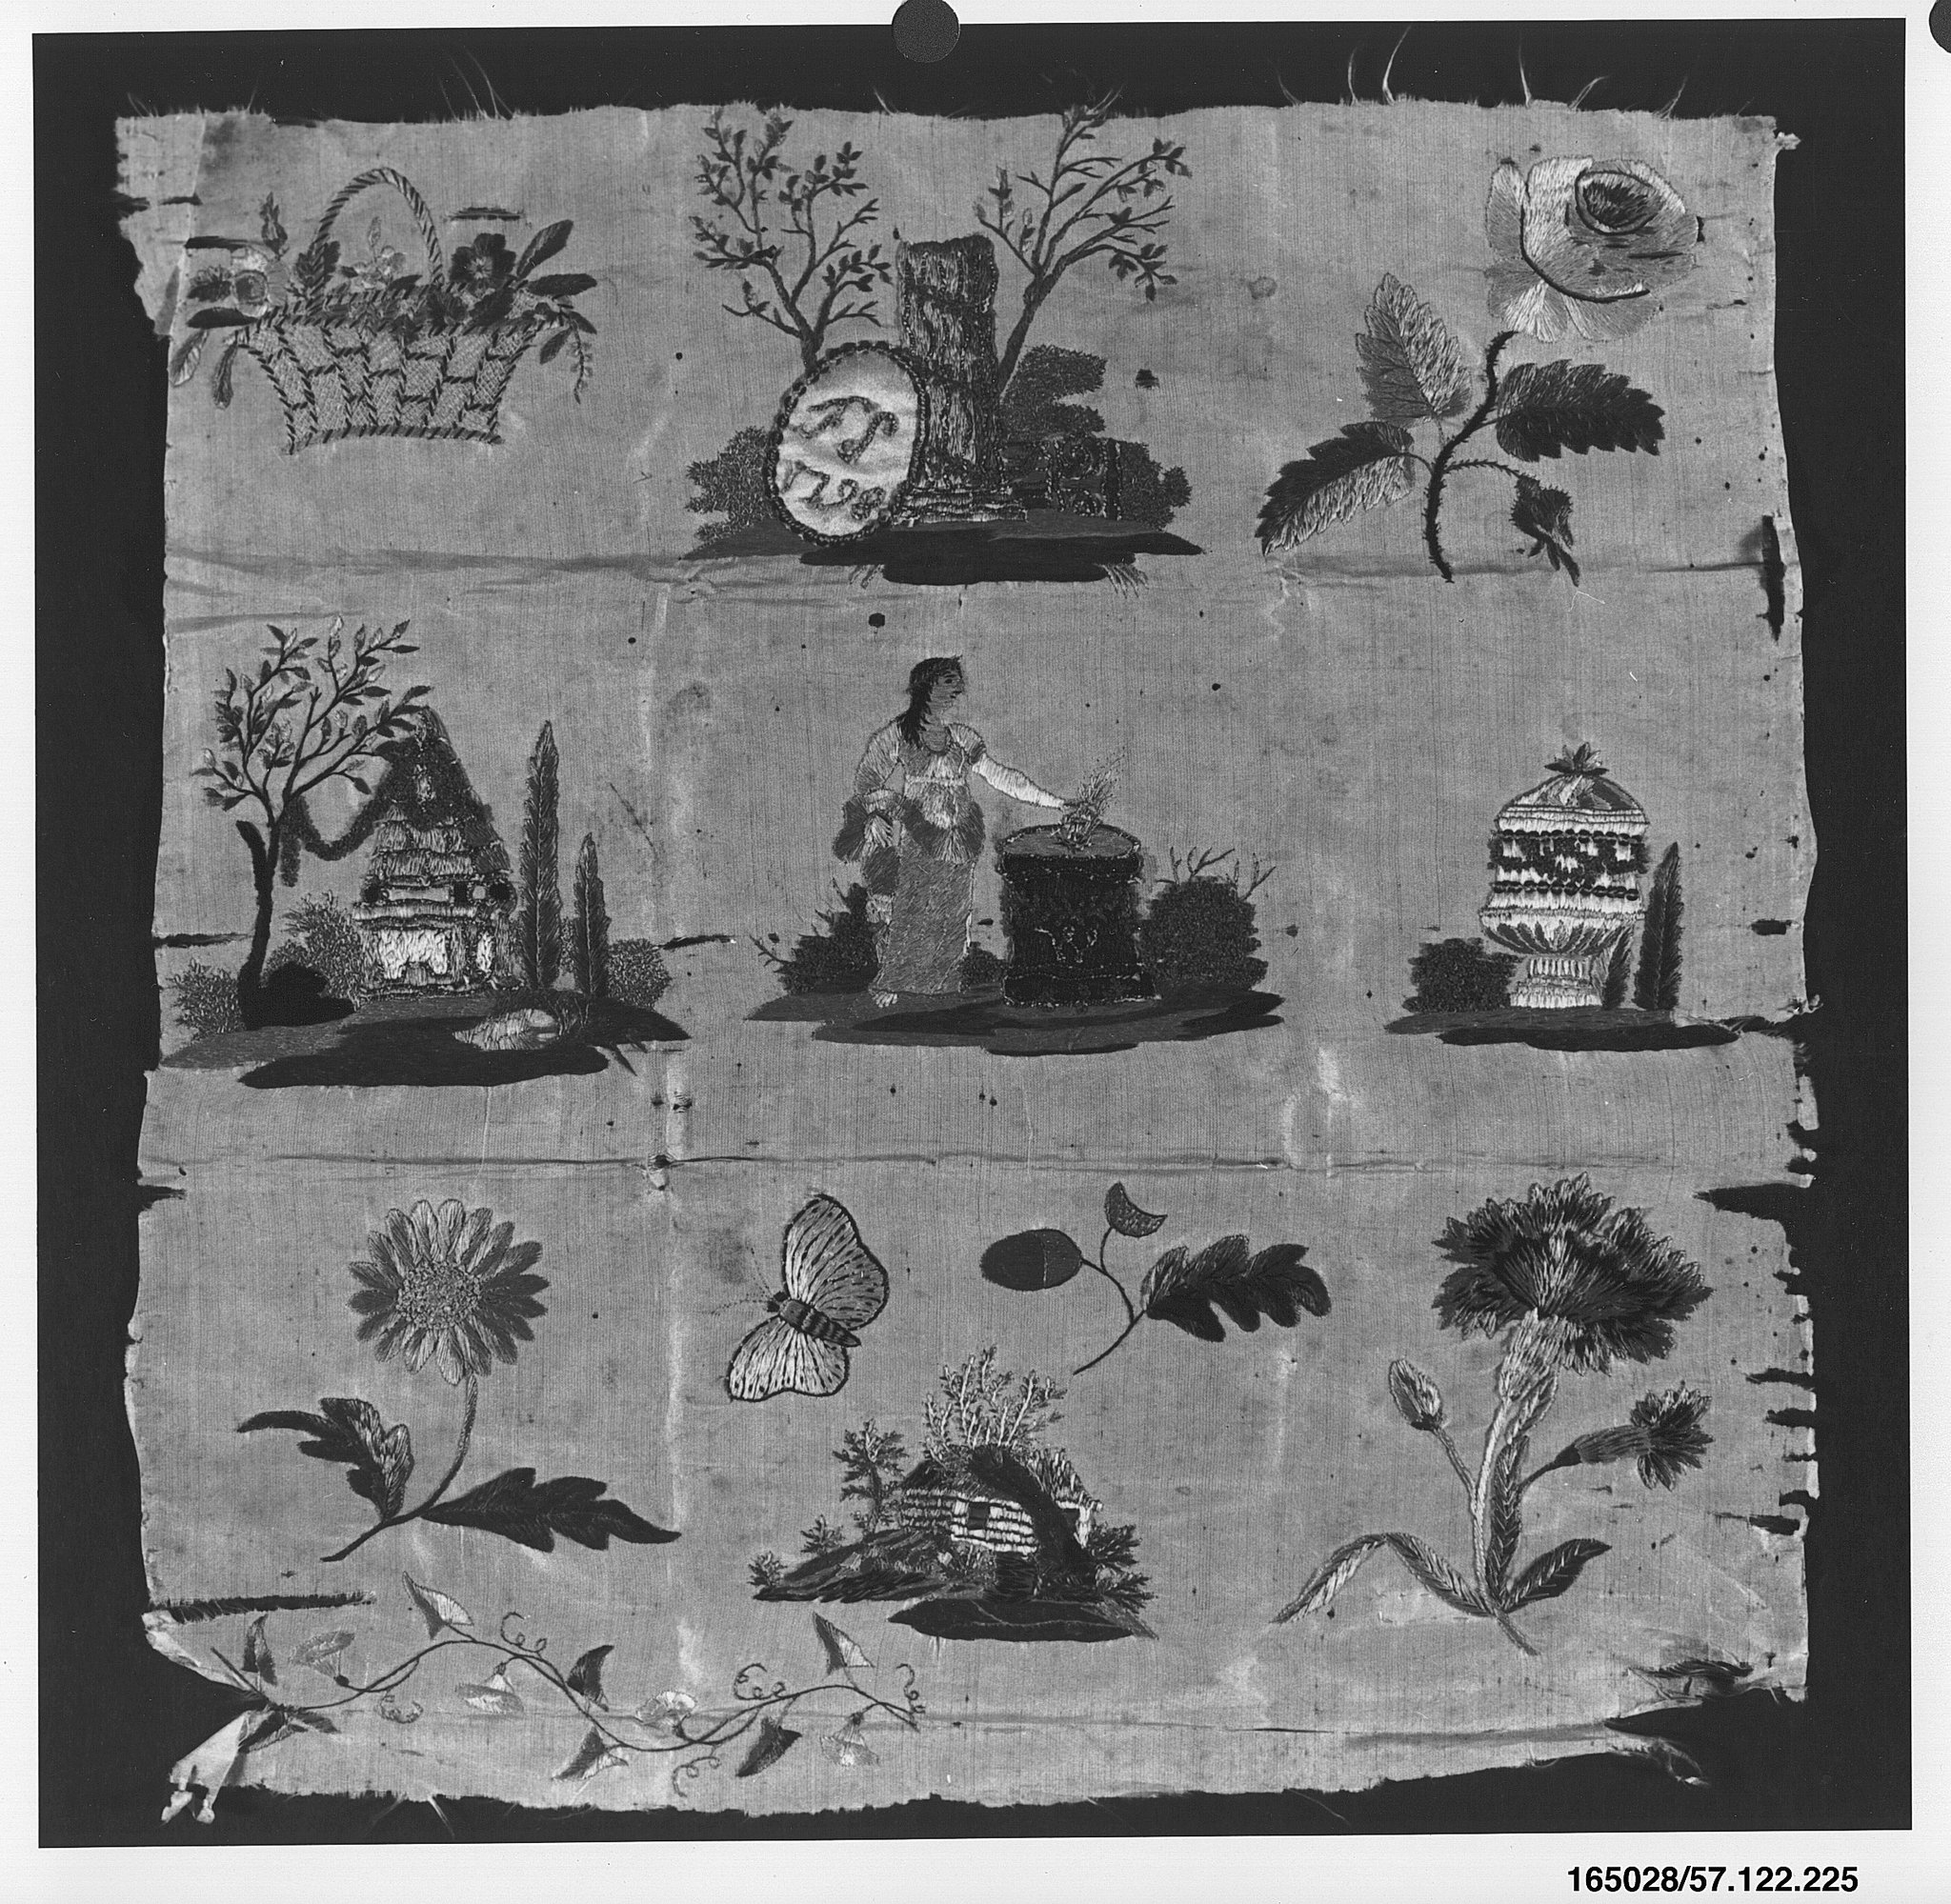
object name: sampler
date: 1798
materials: silk, thread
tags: women,butterflies,flowers